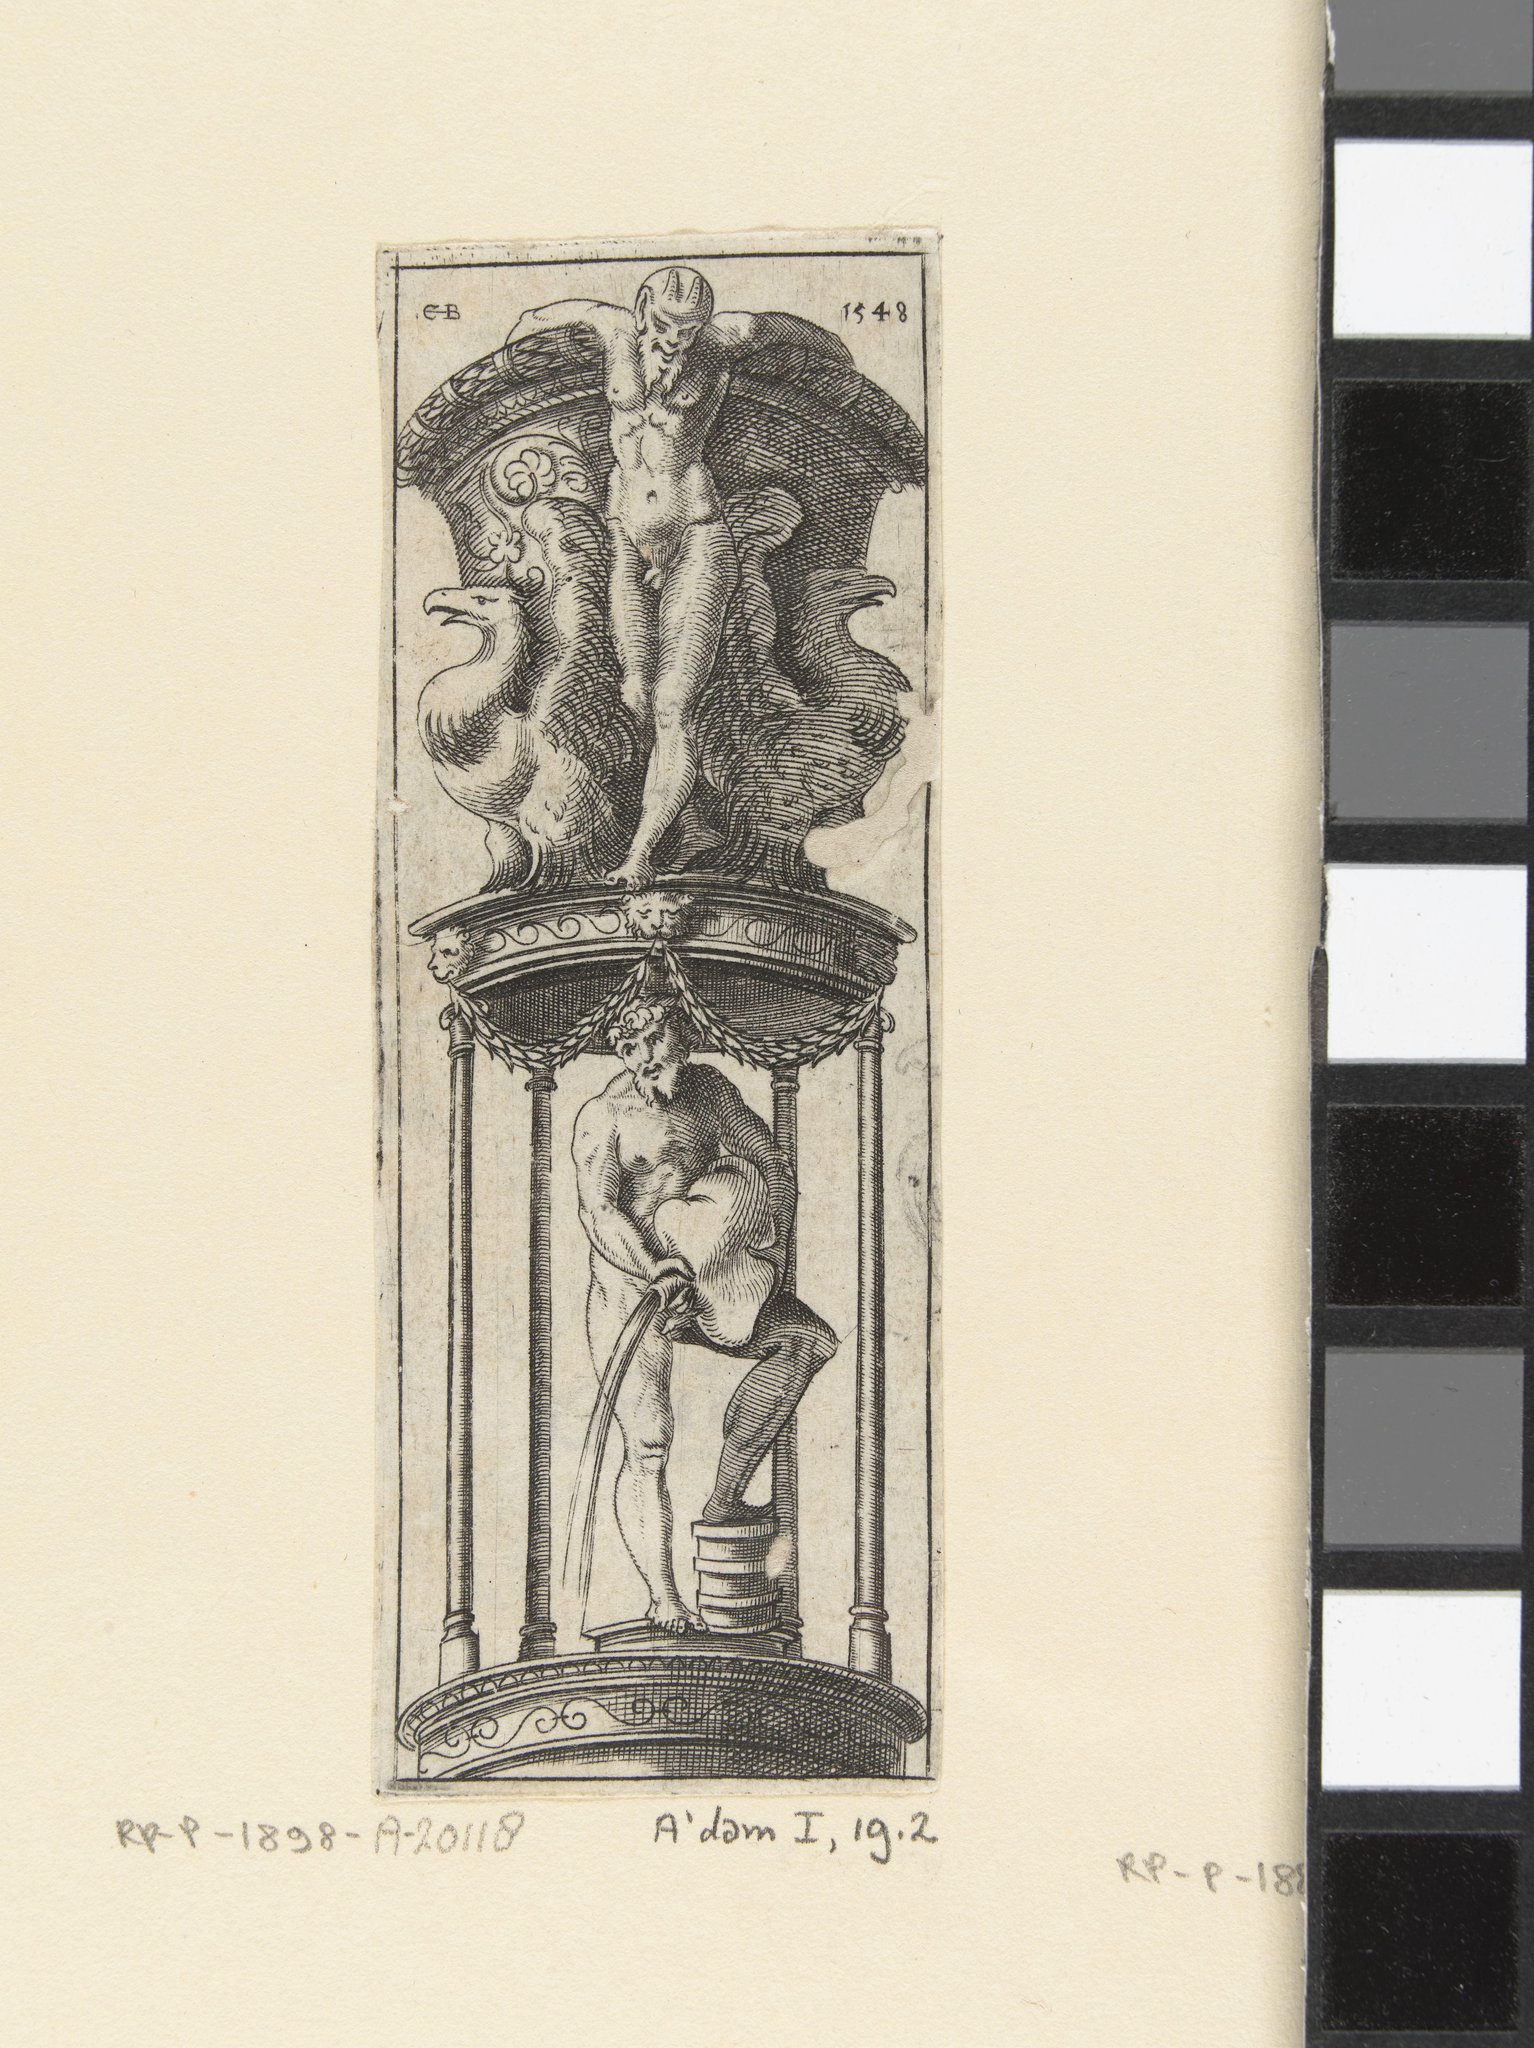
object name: print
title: Onder een baldakijn staat een man die een wijnzak leeg giet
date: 1548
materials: paper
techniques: engraving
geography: netherlands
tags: canopy, baldachin, lambrequin ~ ornament, vase ~ ornament, satyr(s) (in general)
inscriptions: date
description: Het baldakijn wordt gedragen door vier zuilen. Op het baldakijn staat een vaas waaraan een sater hangt, geflankeerd door twee adelaars. Een van 4 bladen afkomstig uit een serie van 6.